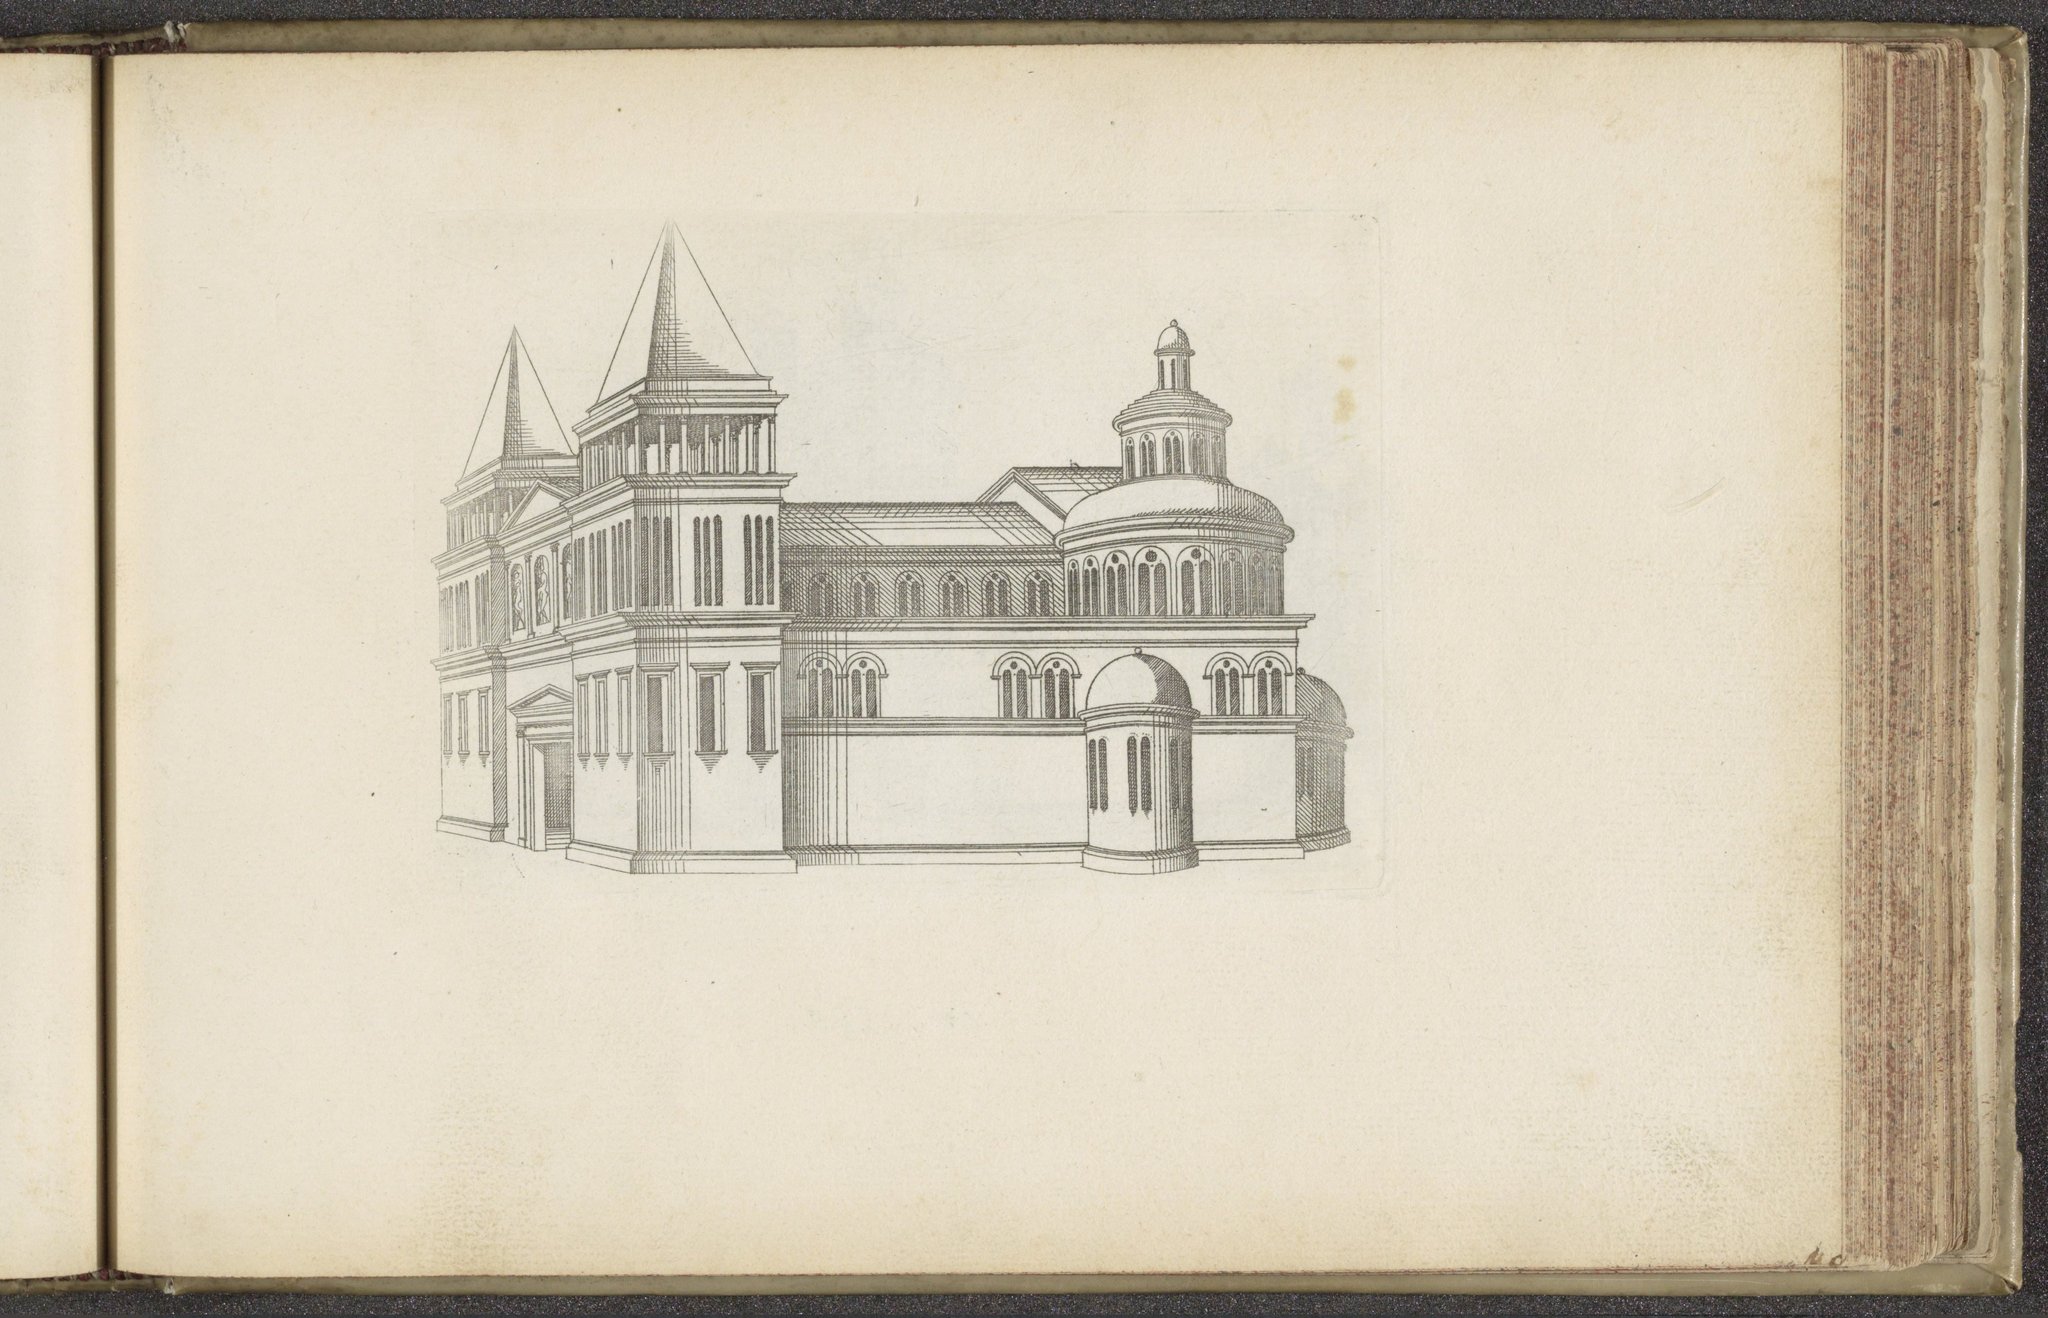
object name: print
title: Iacobus Androuetius Du Cerceau Lectoribus S Quoniam apud veteres alio structurae genere templa (...)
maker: jacques androuet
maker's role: draughtsman, print maker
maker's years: 1515-1584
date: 1550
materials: paper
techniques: etching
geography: orléans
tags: exterior ~ representation of a building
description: Heiligdom met links de toegang met aan weerszijden vierkante torens. Deze prent maakt deel uit van een album.